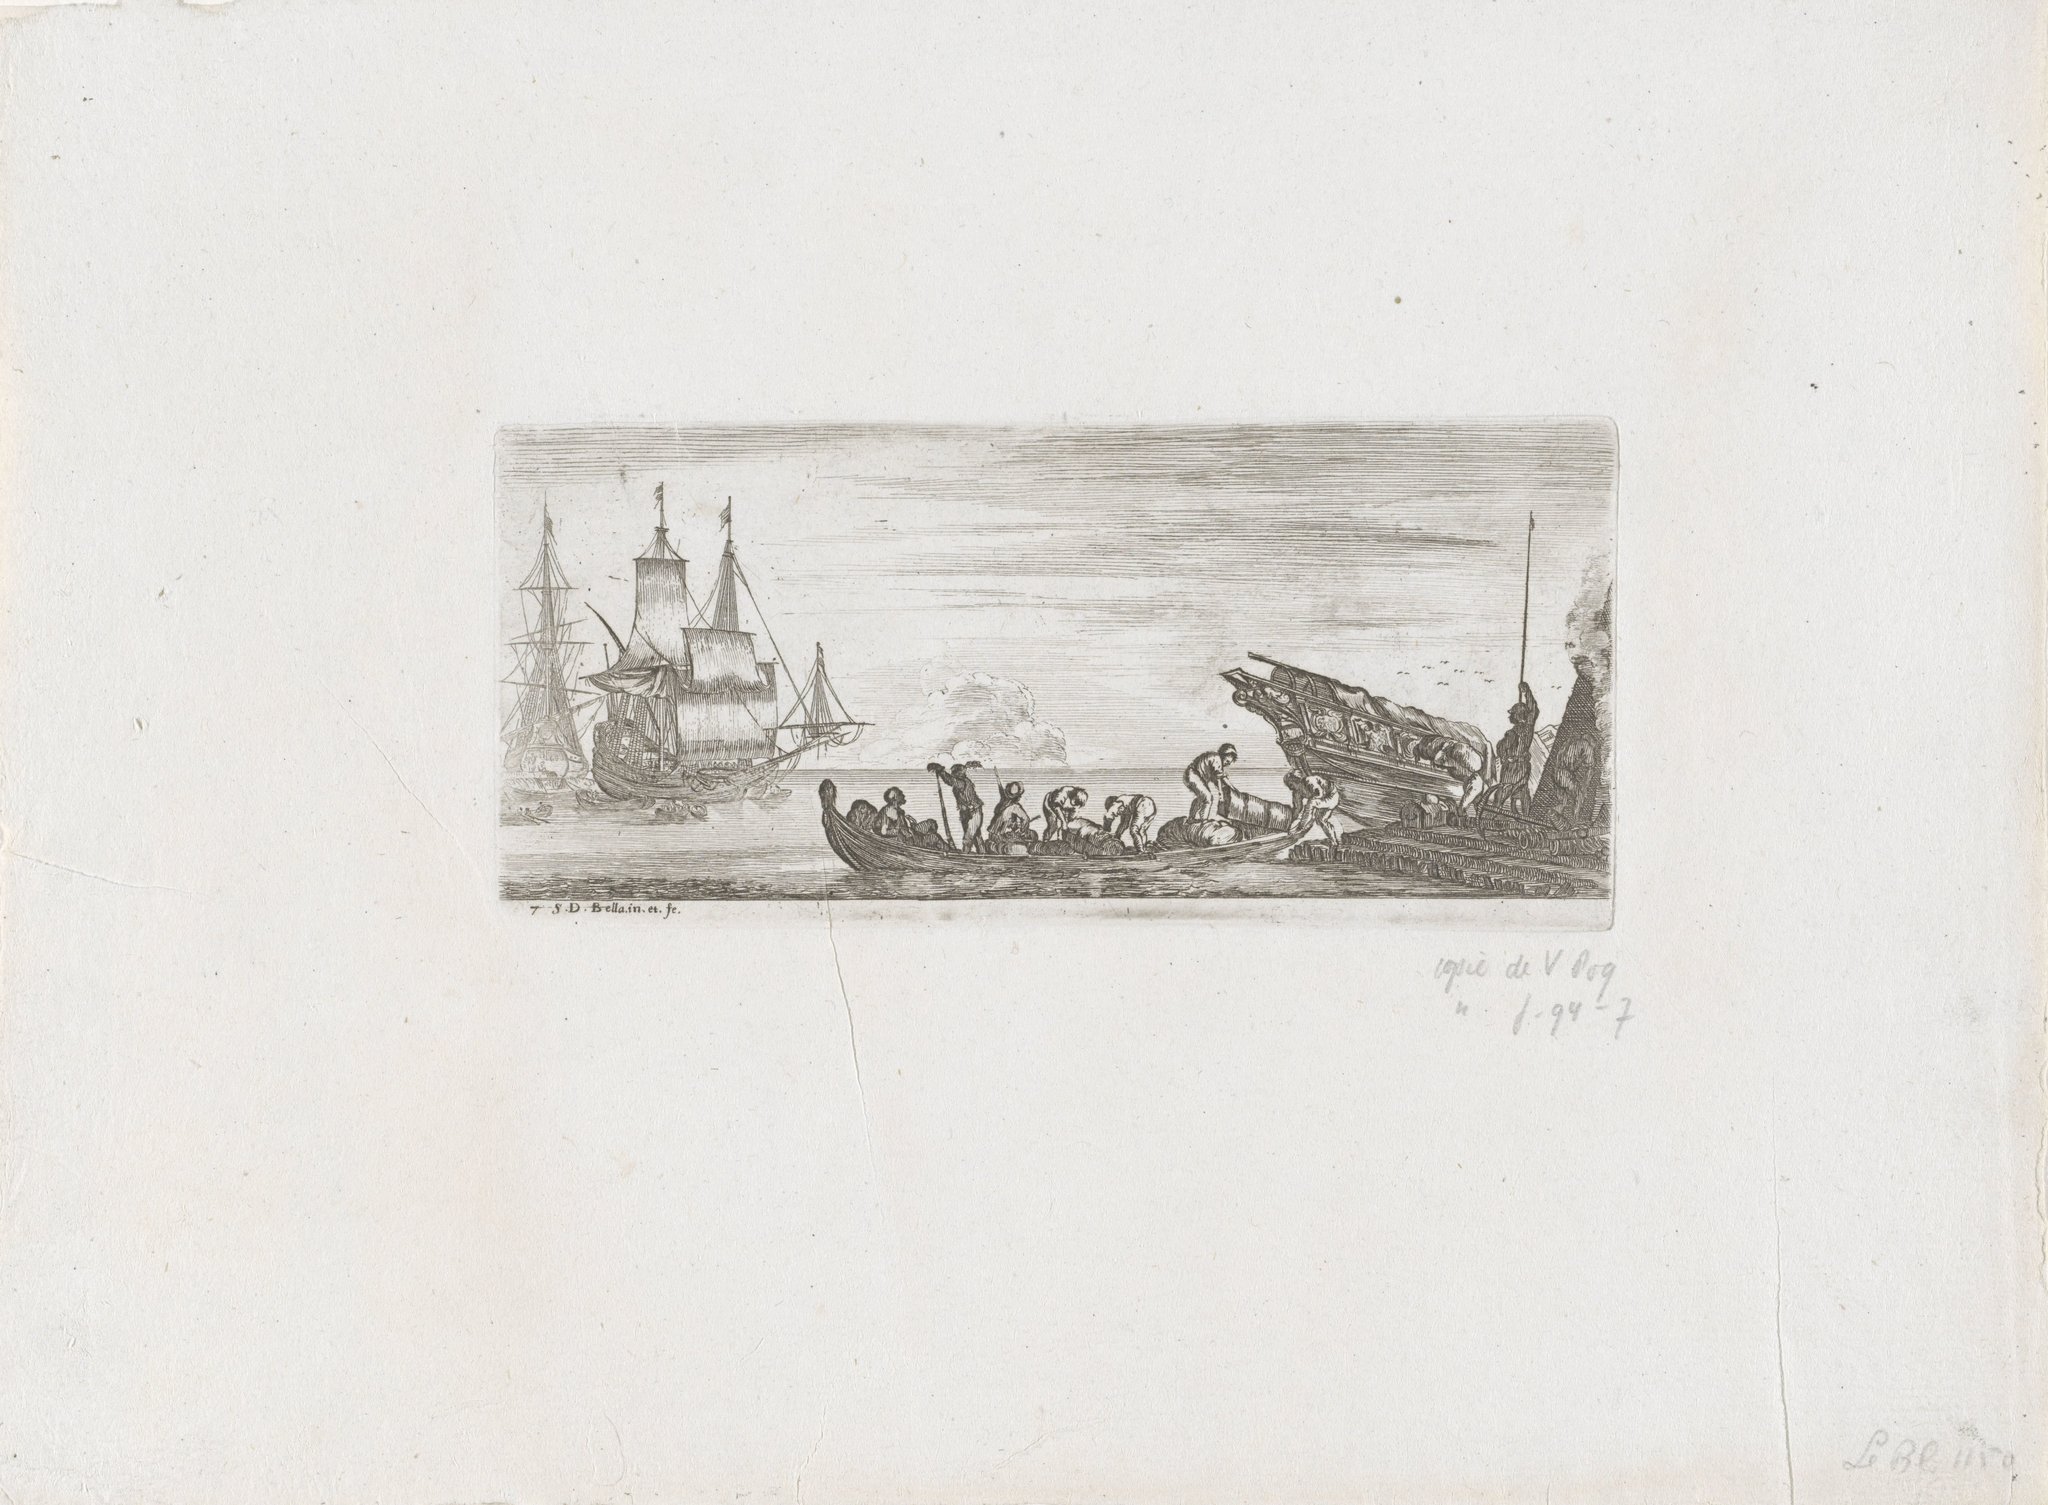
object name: print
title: Havenarbeiders laden een sloep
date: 1620-1664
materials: paper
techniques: etching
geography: italy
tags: harbour, dock labourer, ships (in general), pier, quay, wharf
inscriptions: collector's mark: Lugt 2228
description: Prent uit een reeks van negen prenten. Zeven prenten zijn spiegelbeeldige en genummerde kopieën naar prenten van Stefano della Bella. Twee prenten zijn nieuwe inventies. Mogelijk is deze gekopieerde reeks ook door Della Bella zelf vervaardigd.